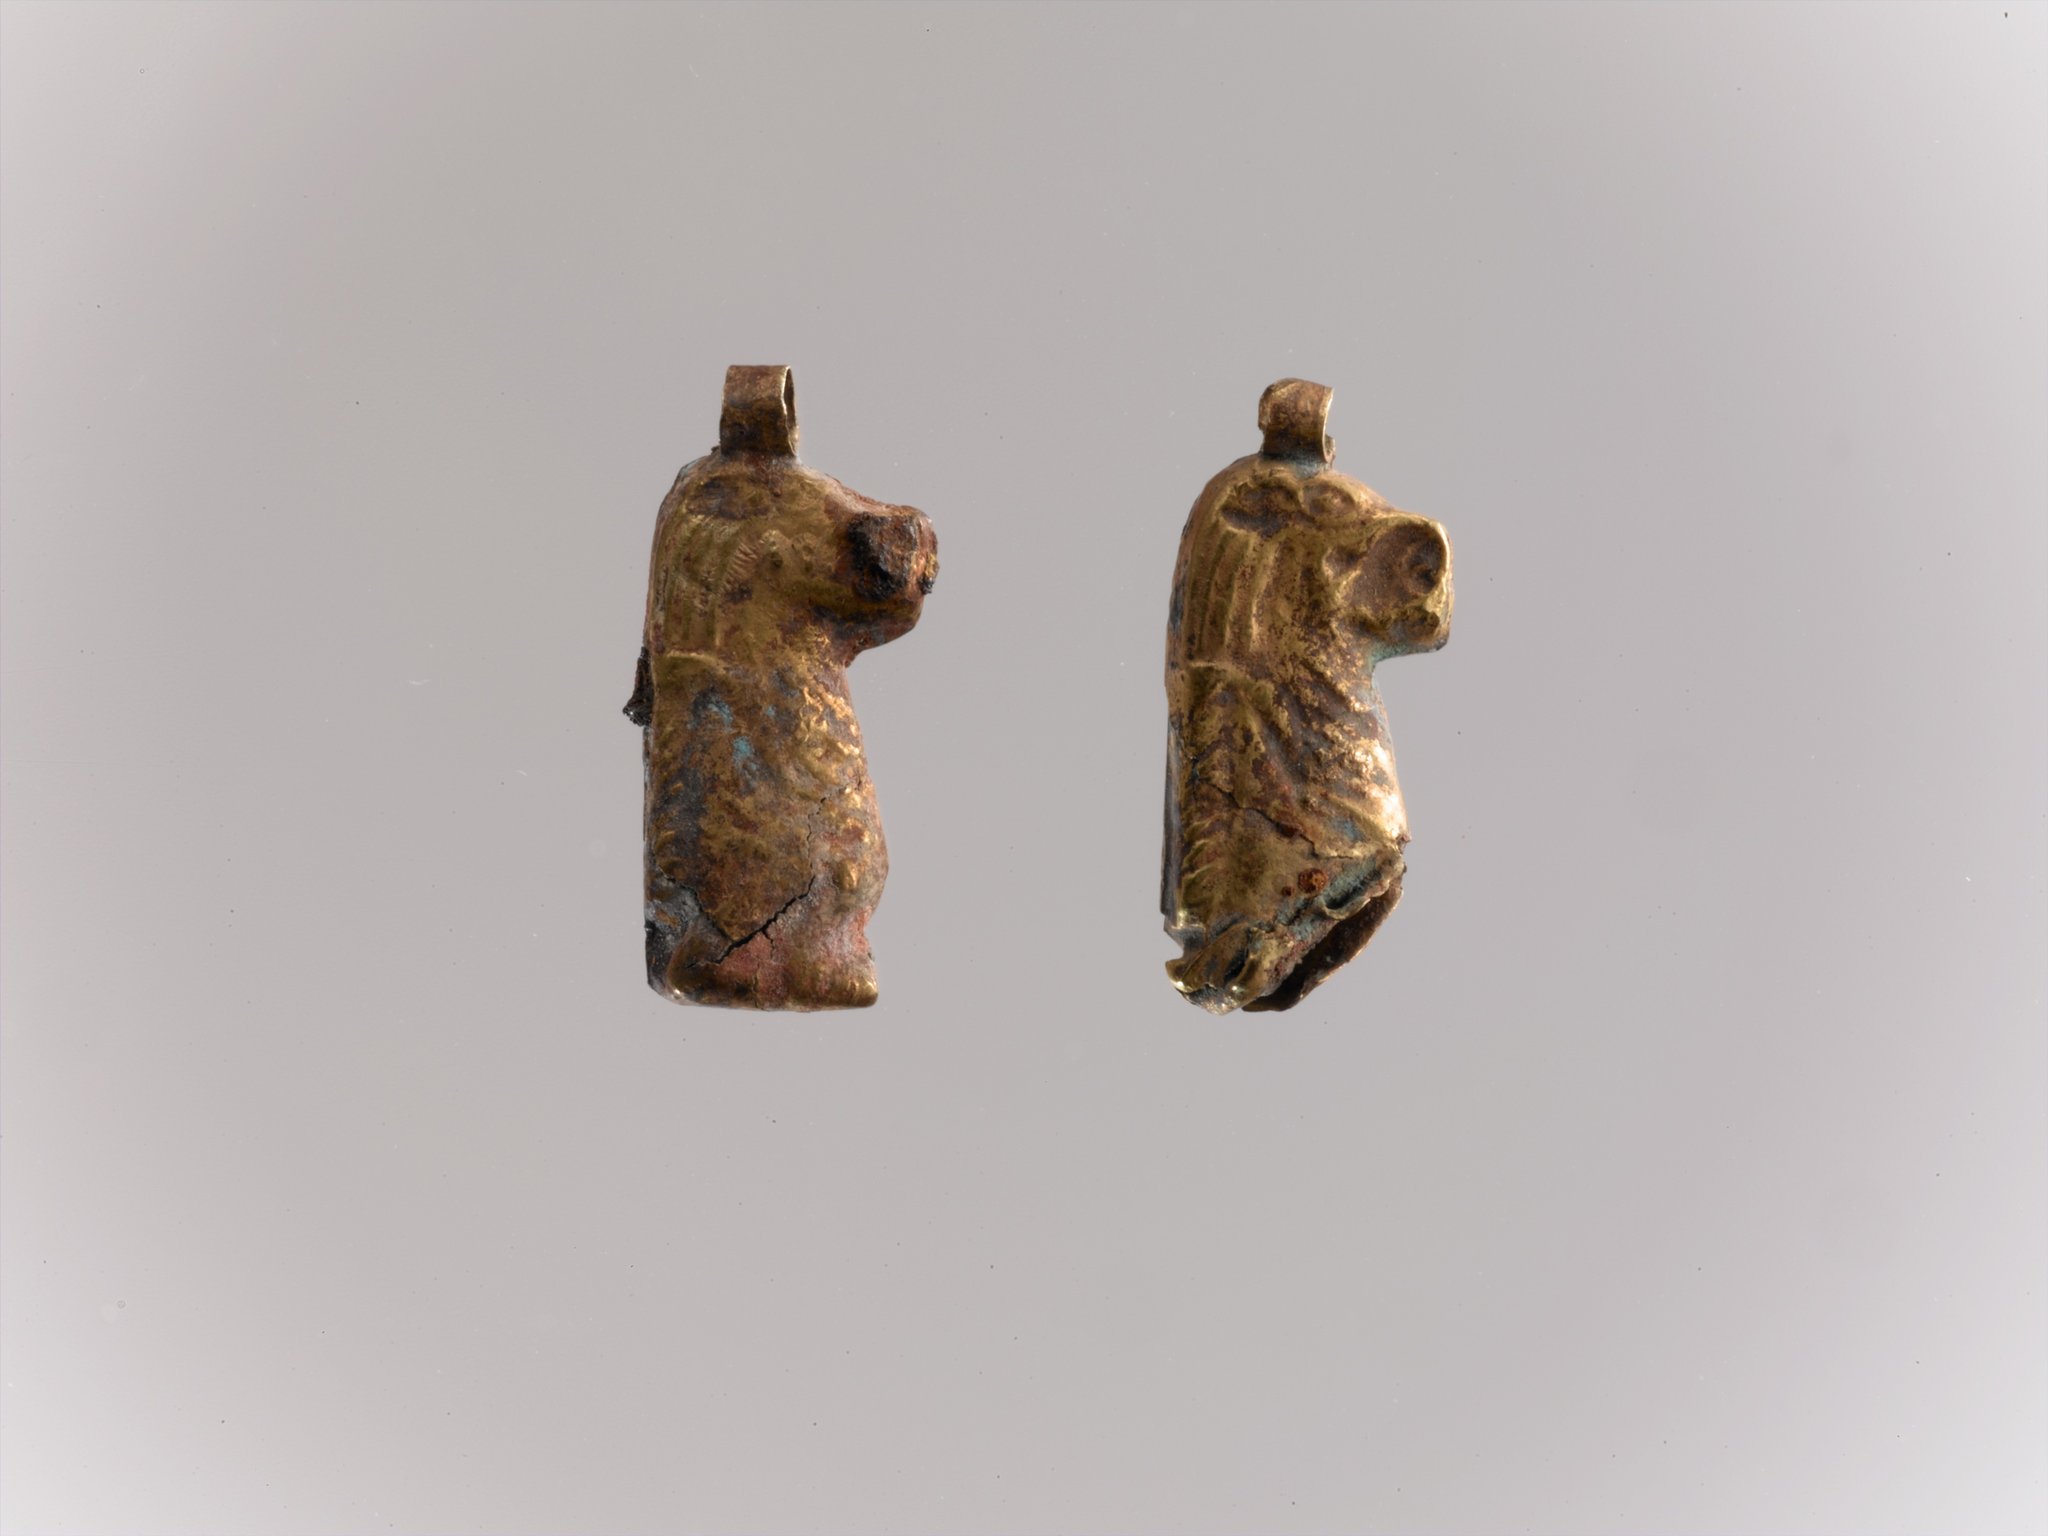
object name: amulet, hippo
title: Hippopotamus Amulet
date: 1479-1425 BCE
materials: gold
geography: upper egypt, thebes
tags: hippos